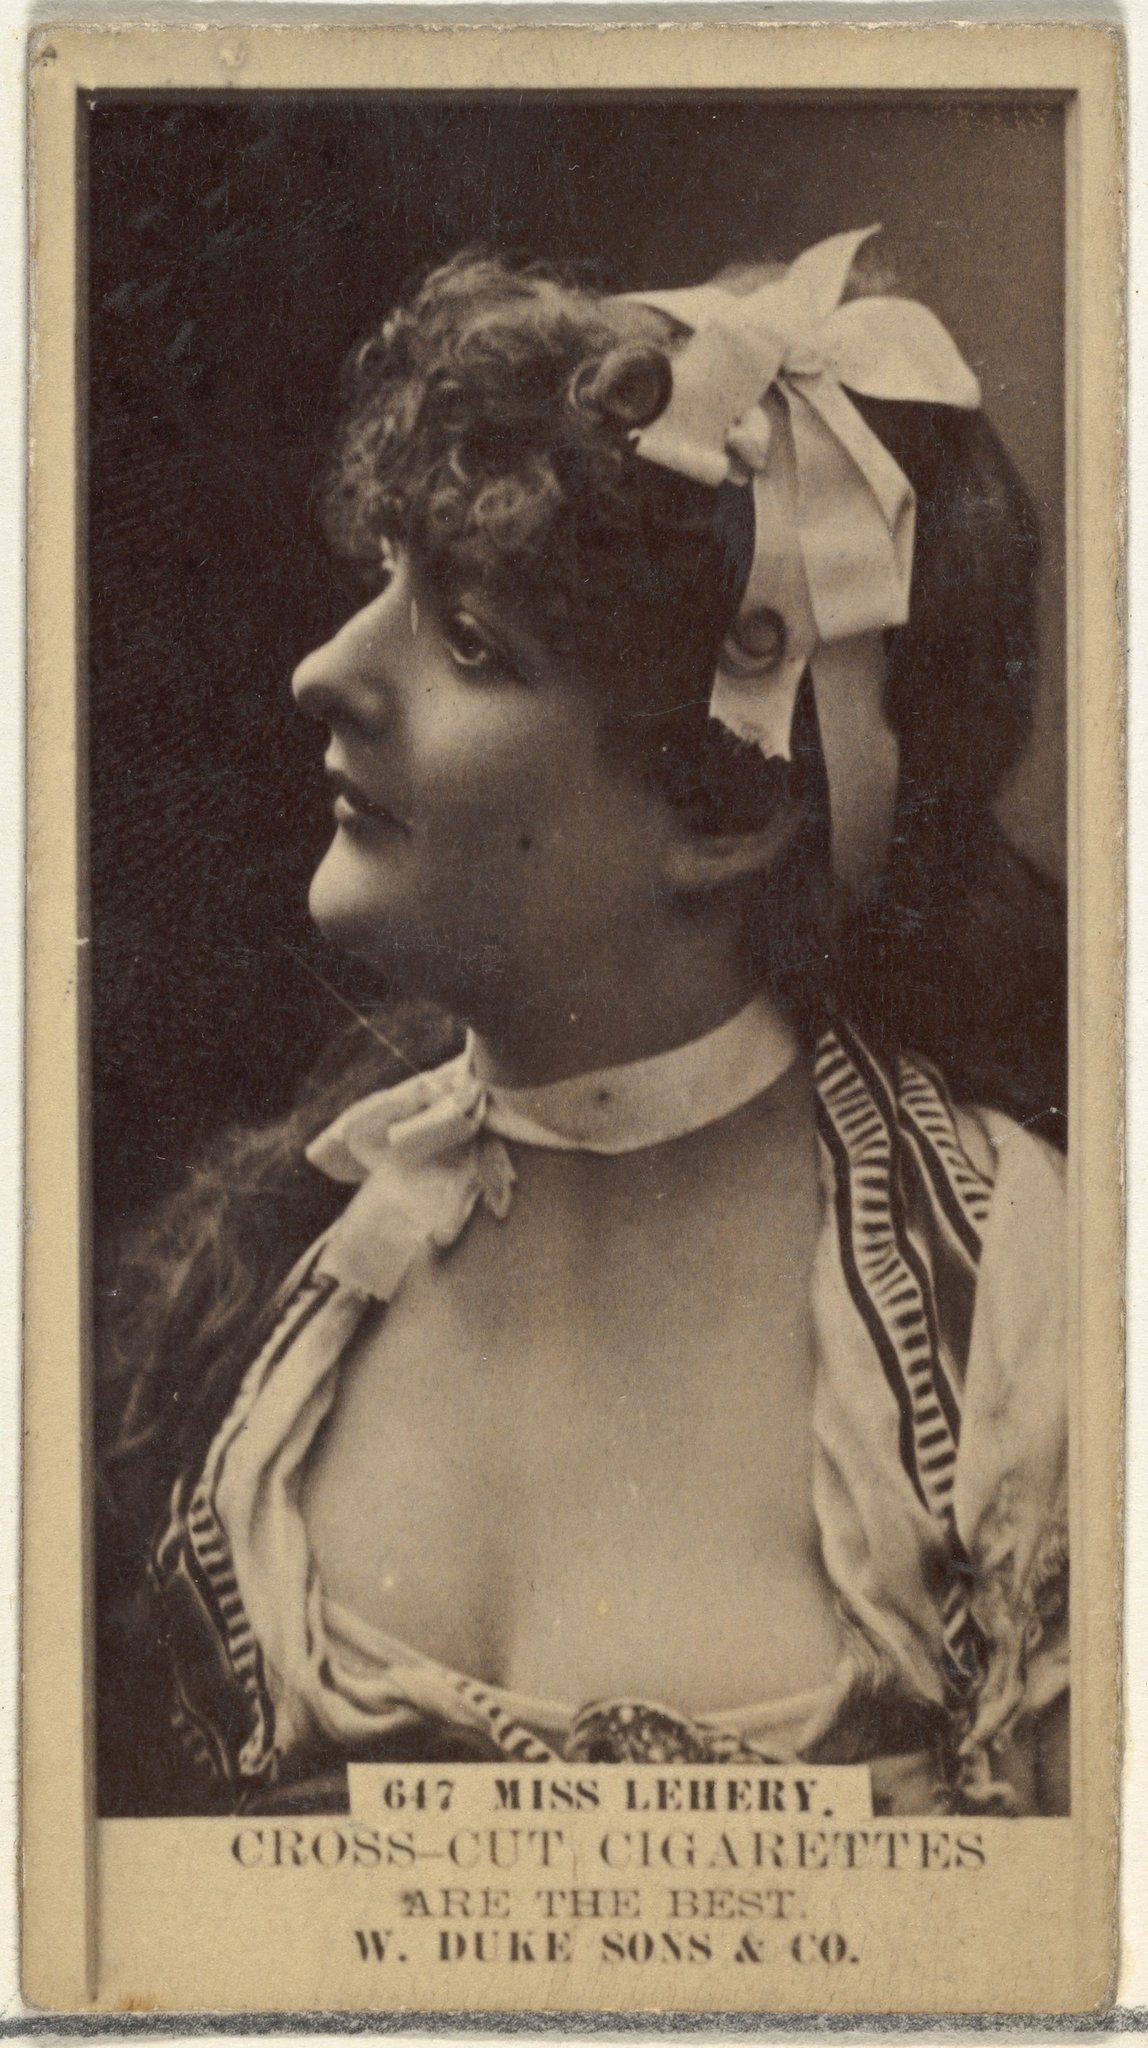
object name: photograph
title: Card Number 647, Miss Lehery, from the Actors and Actresses series (N145-3) issued by Duke Sons & Co. to promote Cross Cut Cigarettes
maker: w. duke, sons & co.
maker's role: publisher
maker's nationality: american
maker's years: 1870-1920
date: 1880-1889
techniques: albumen silver print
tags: women,actresses